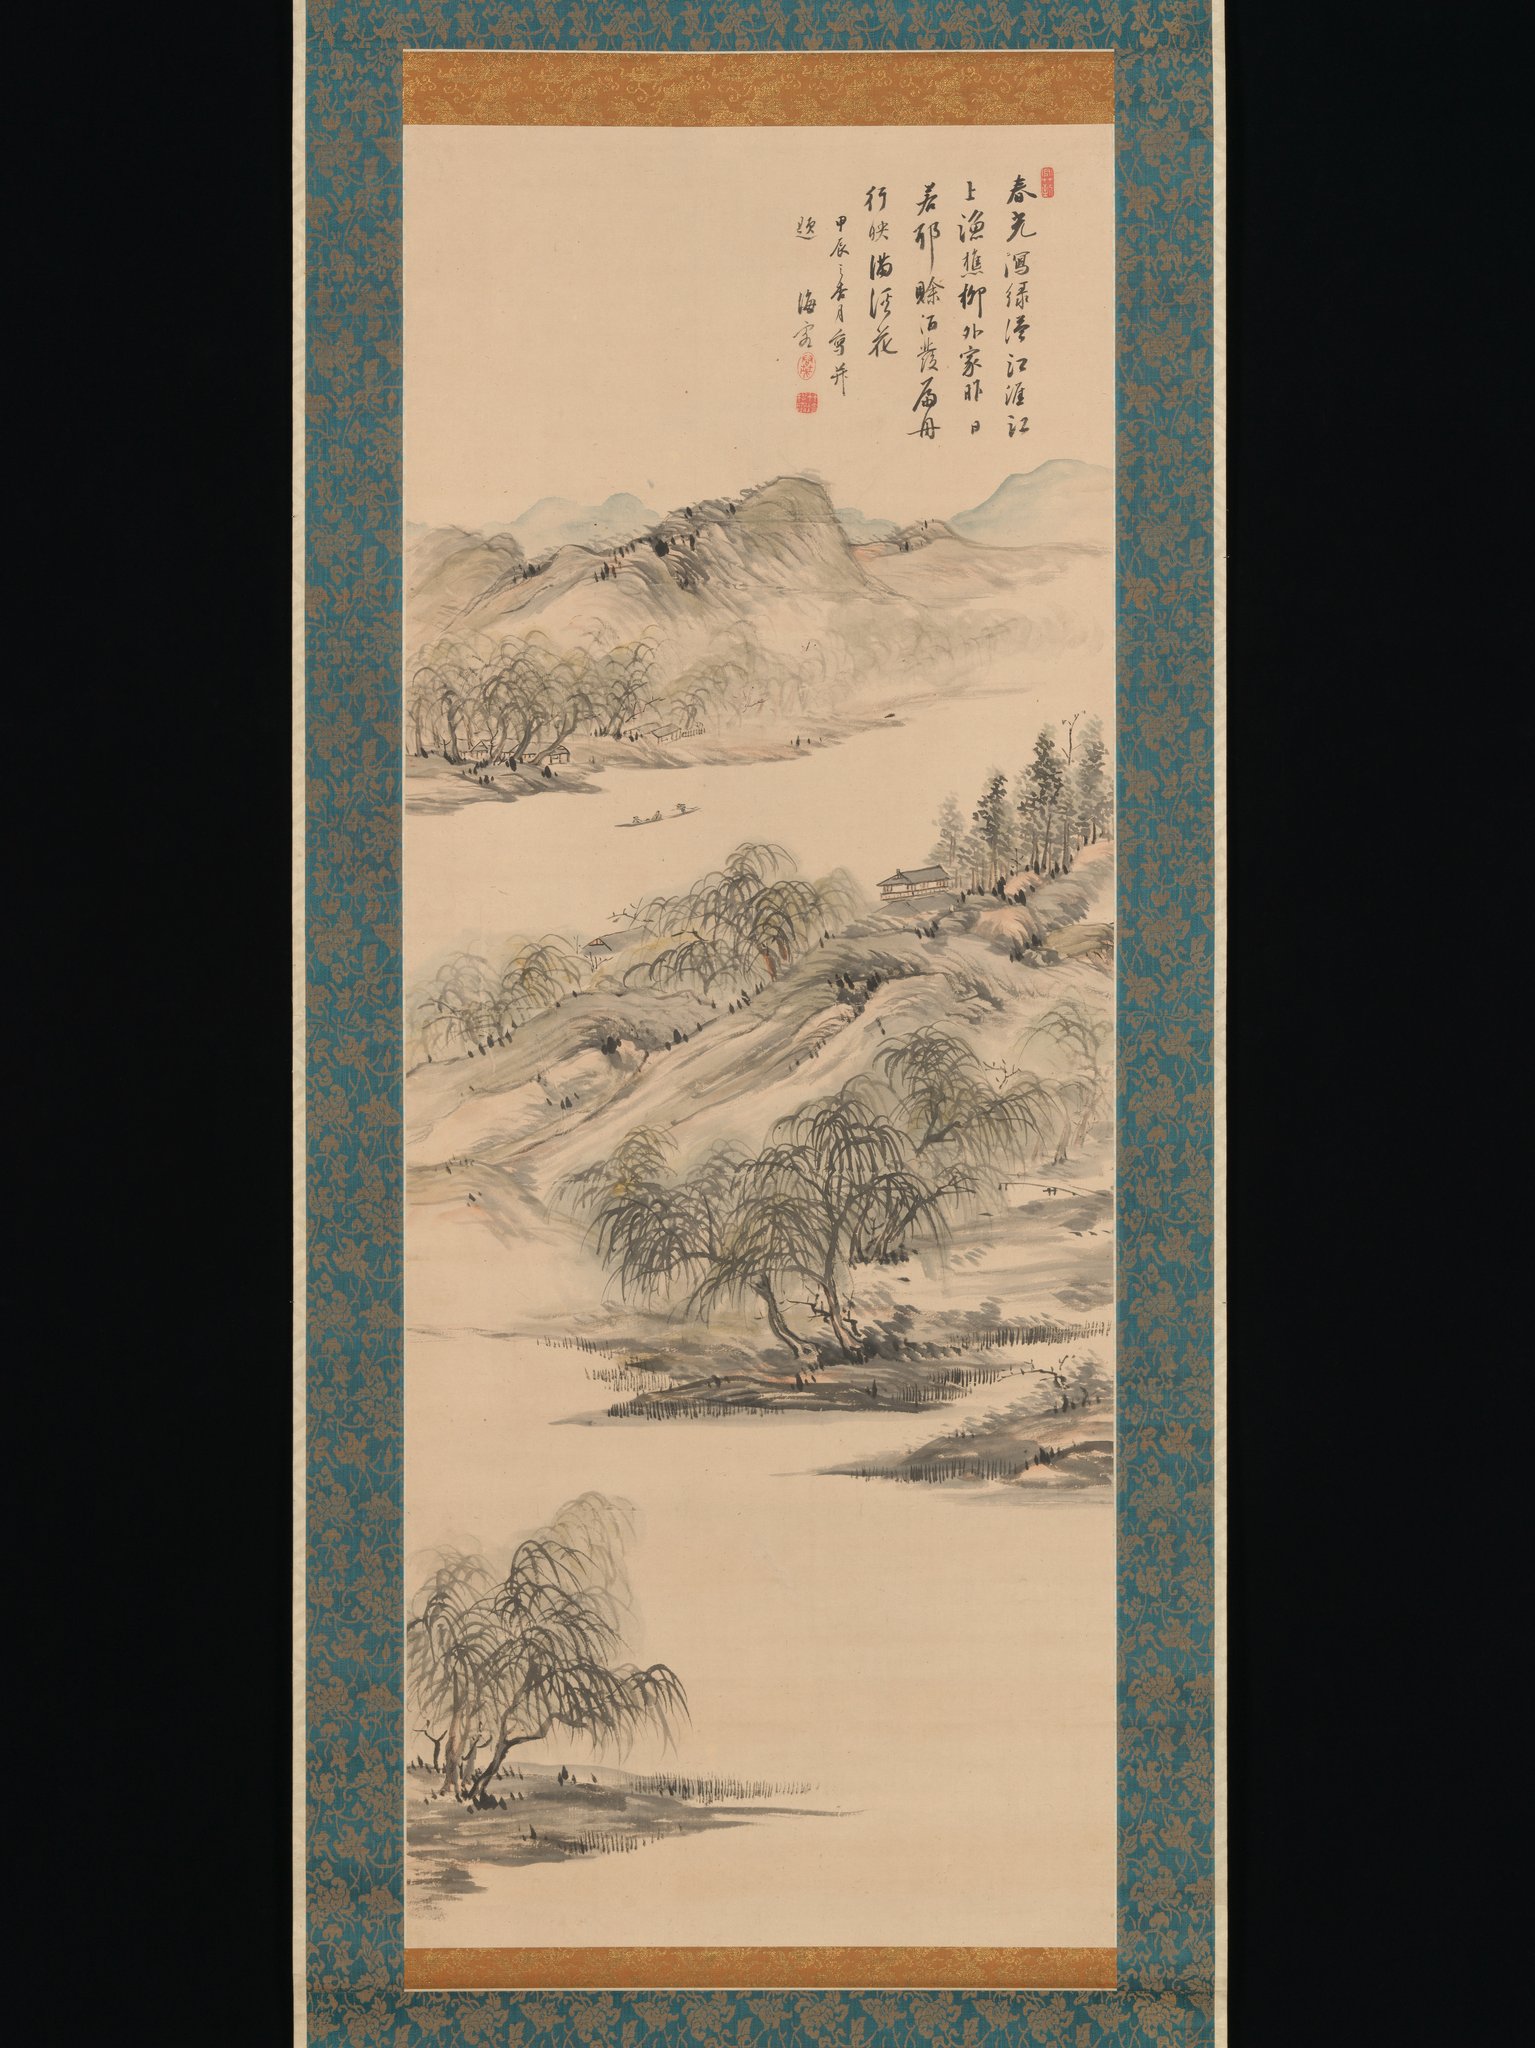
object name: hanging scroll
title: Spring Landscape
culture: japanese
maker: nukina kaioku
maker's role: artist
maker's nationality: japanese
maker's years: 1778-1863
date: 1844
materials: ink, paper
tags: landscapes